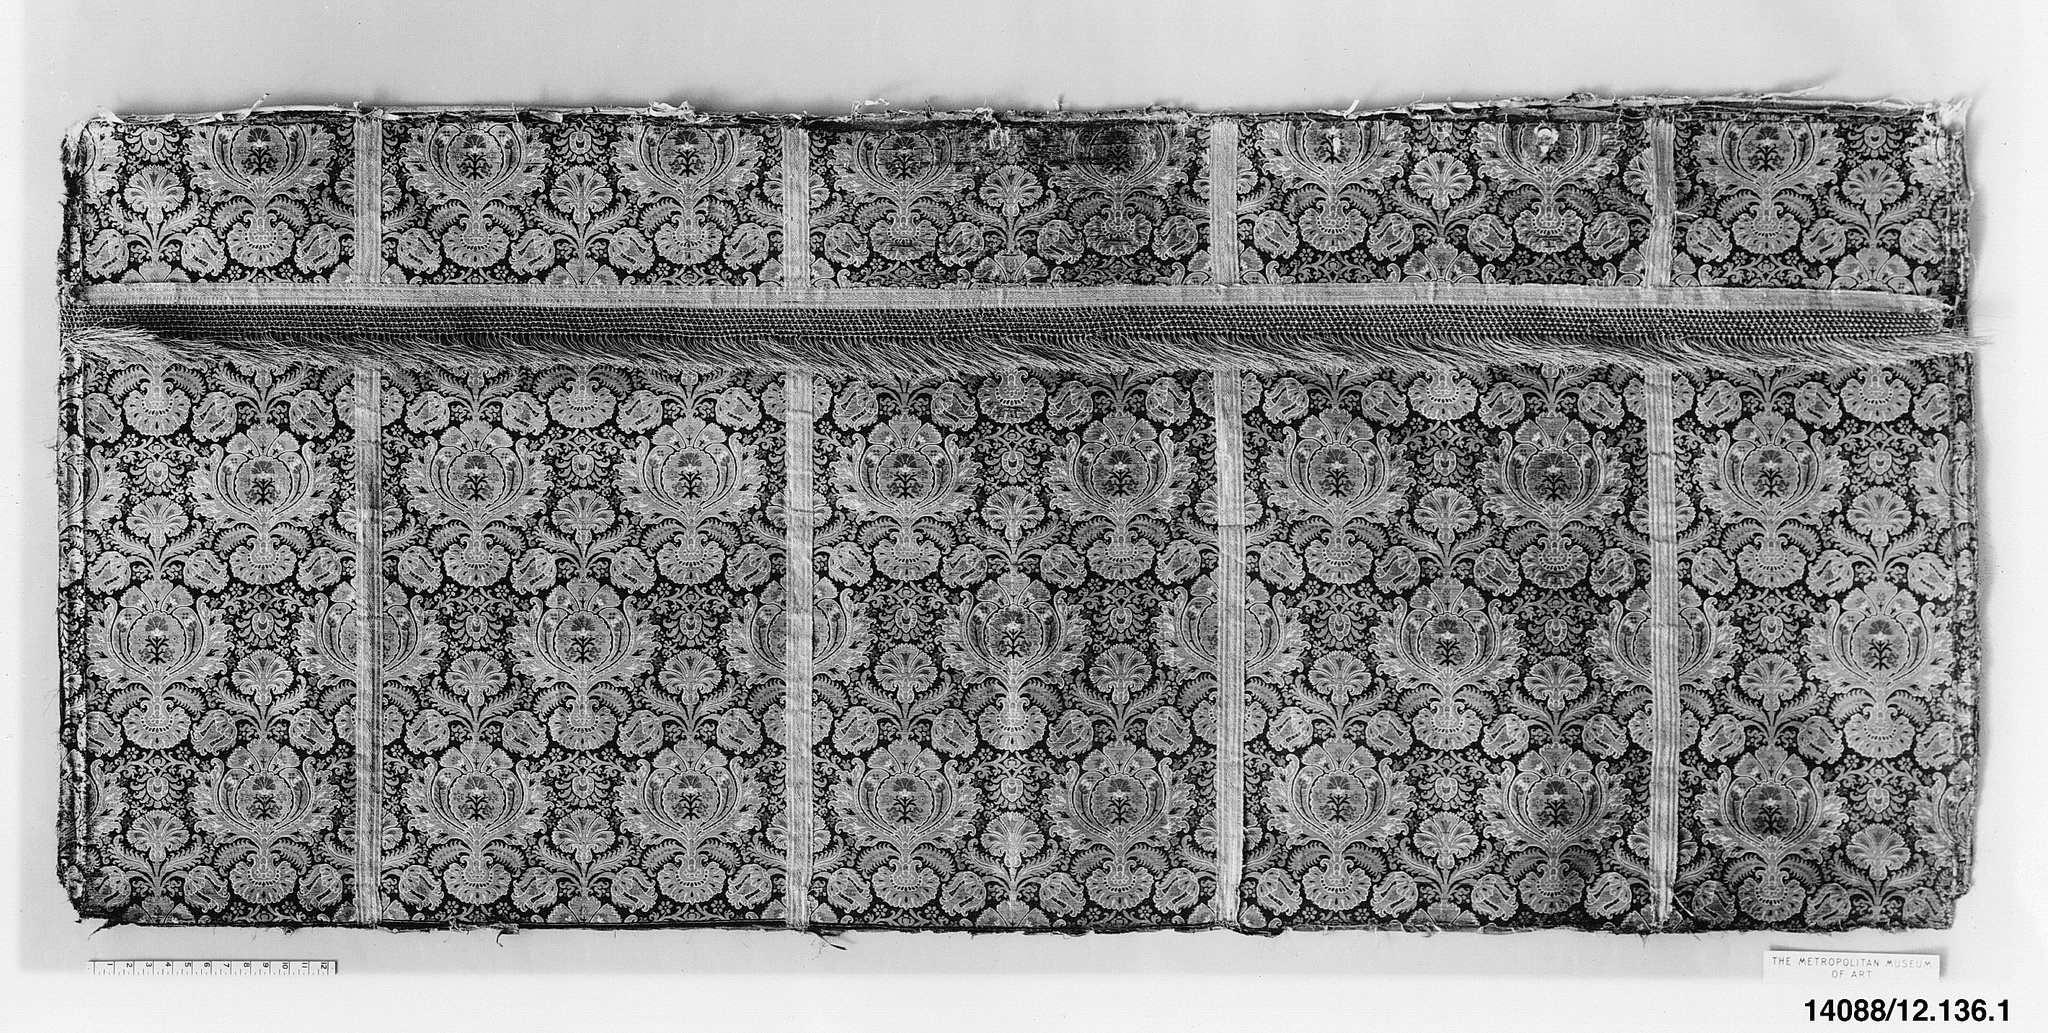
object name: piece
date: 1501-1600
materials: metal thread, silk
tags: flowers,leaves